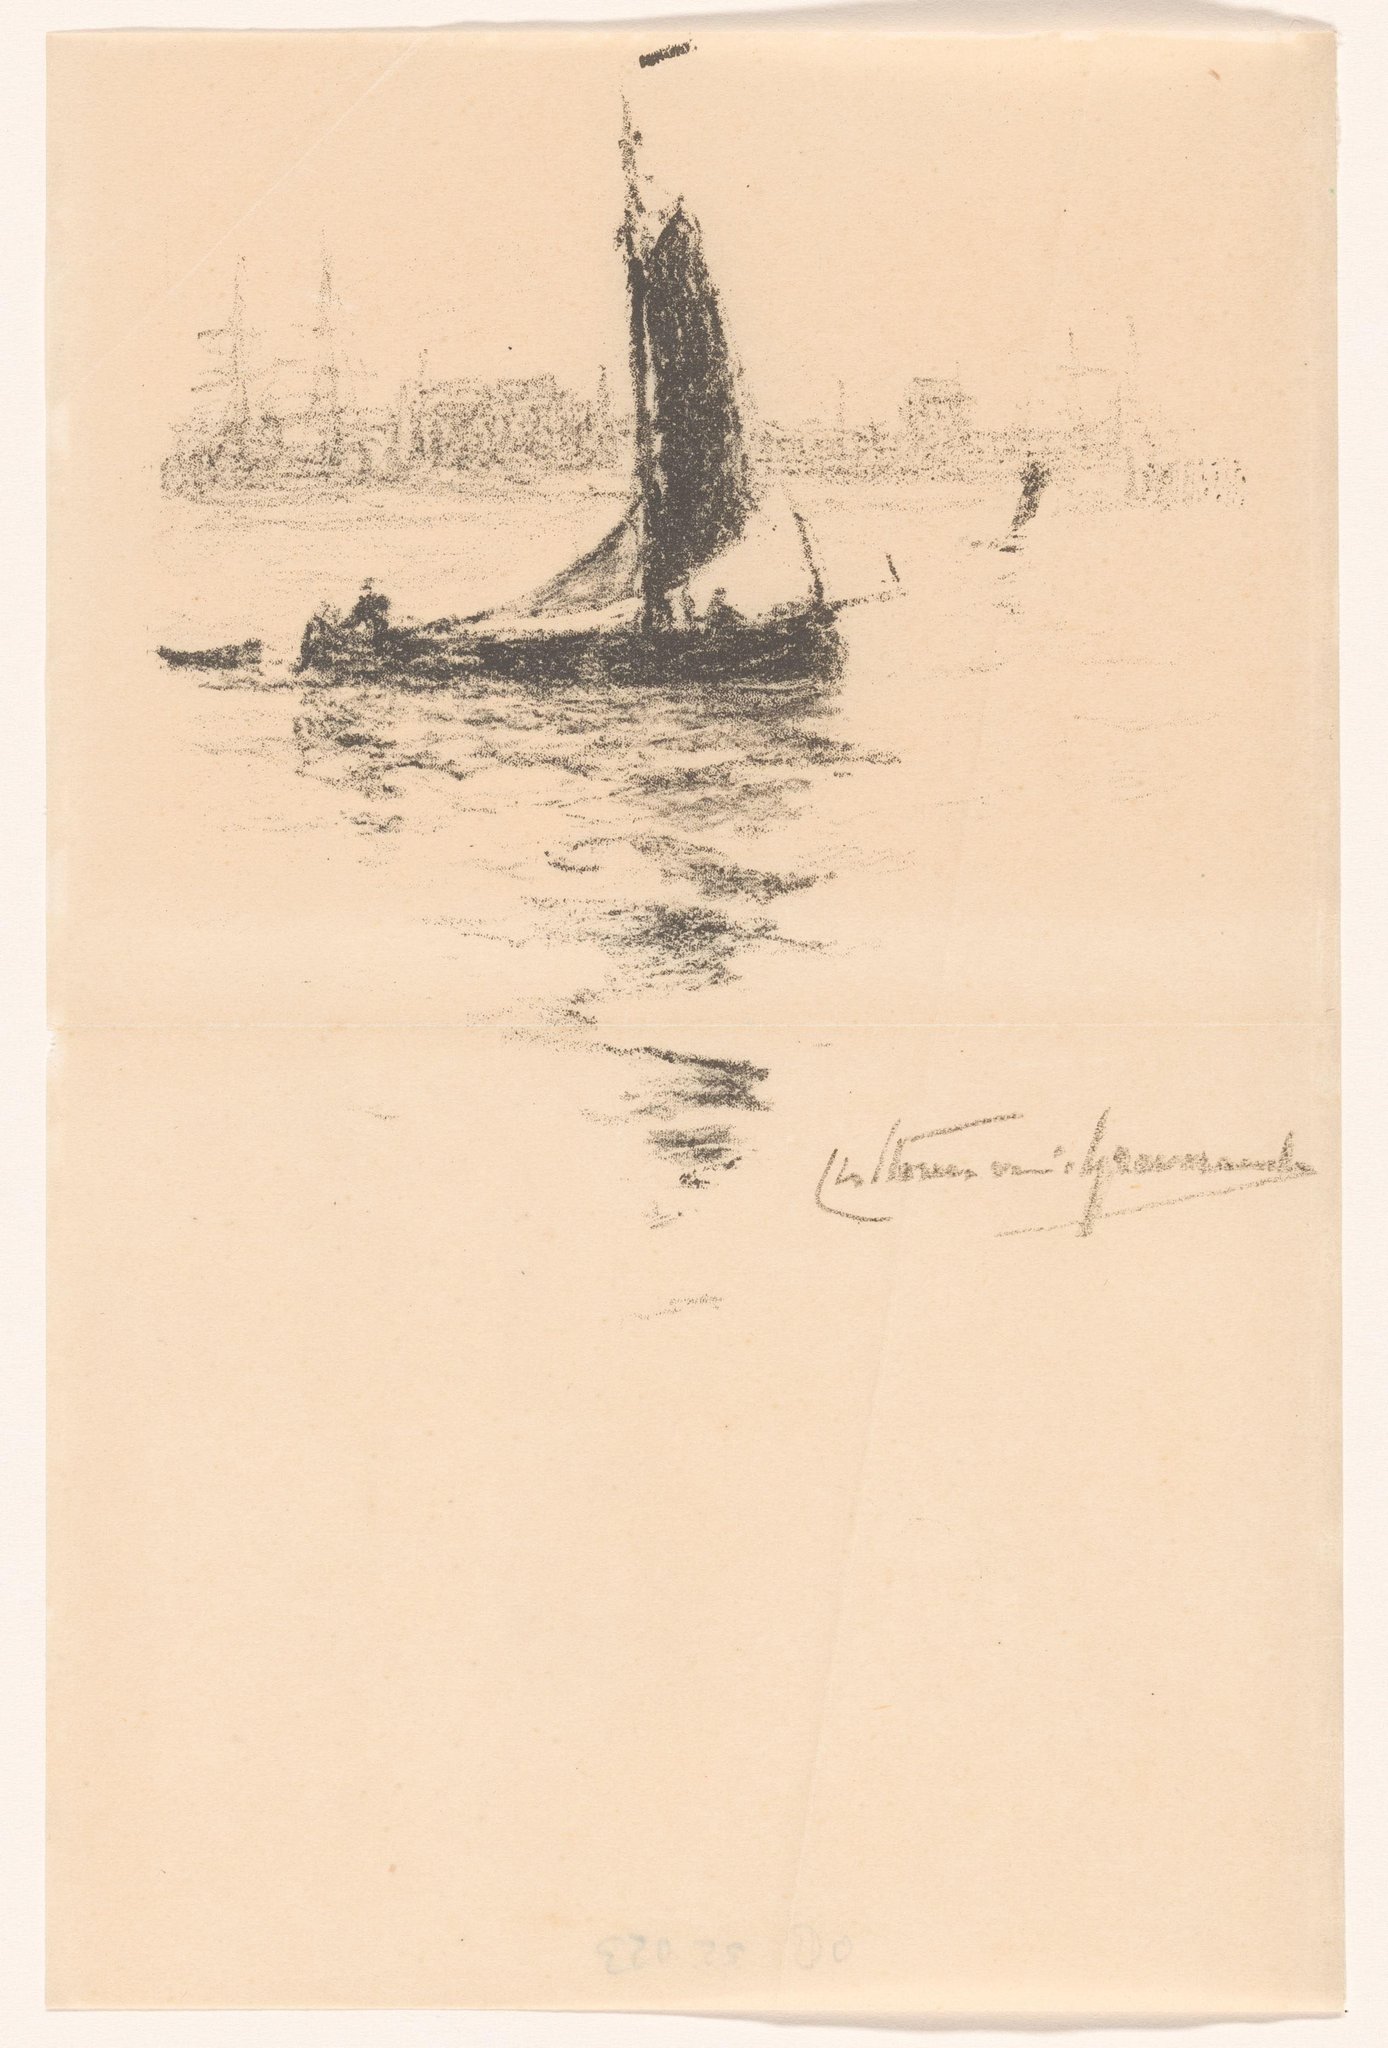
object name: print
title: Zeilboot voor een stad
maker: carel nicolaas storm van s-gravesande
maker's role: draughtsman, print maker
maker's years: 1841-1924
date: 1851-1924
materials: paper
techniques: lithograph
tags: sailing-ship, sailing-boat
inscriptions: collector's mark: Lugt 2228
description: Mogelijk vermeld in: Storm van 's-Gravesande, Charles. Catalogue des eaux-fortes et lithographies. New York: s.n., 1903, of in een onbekende latere uitgave van het manuscript. Vermoedelijk vermeld als catalogusnummer 83.